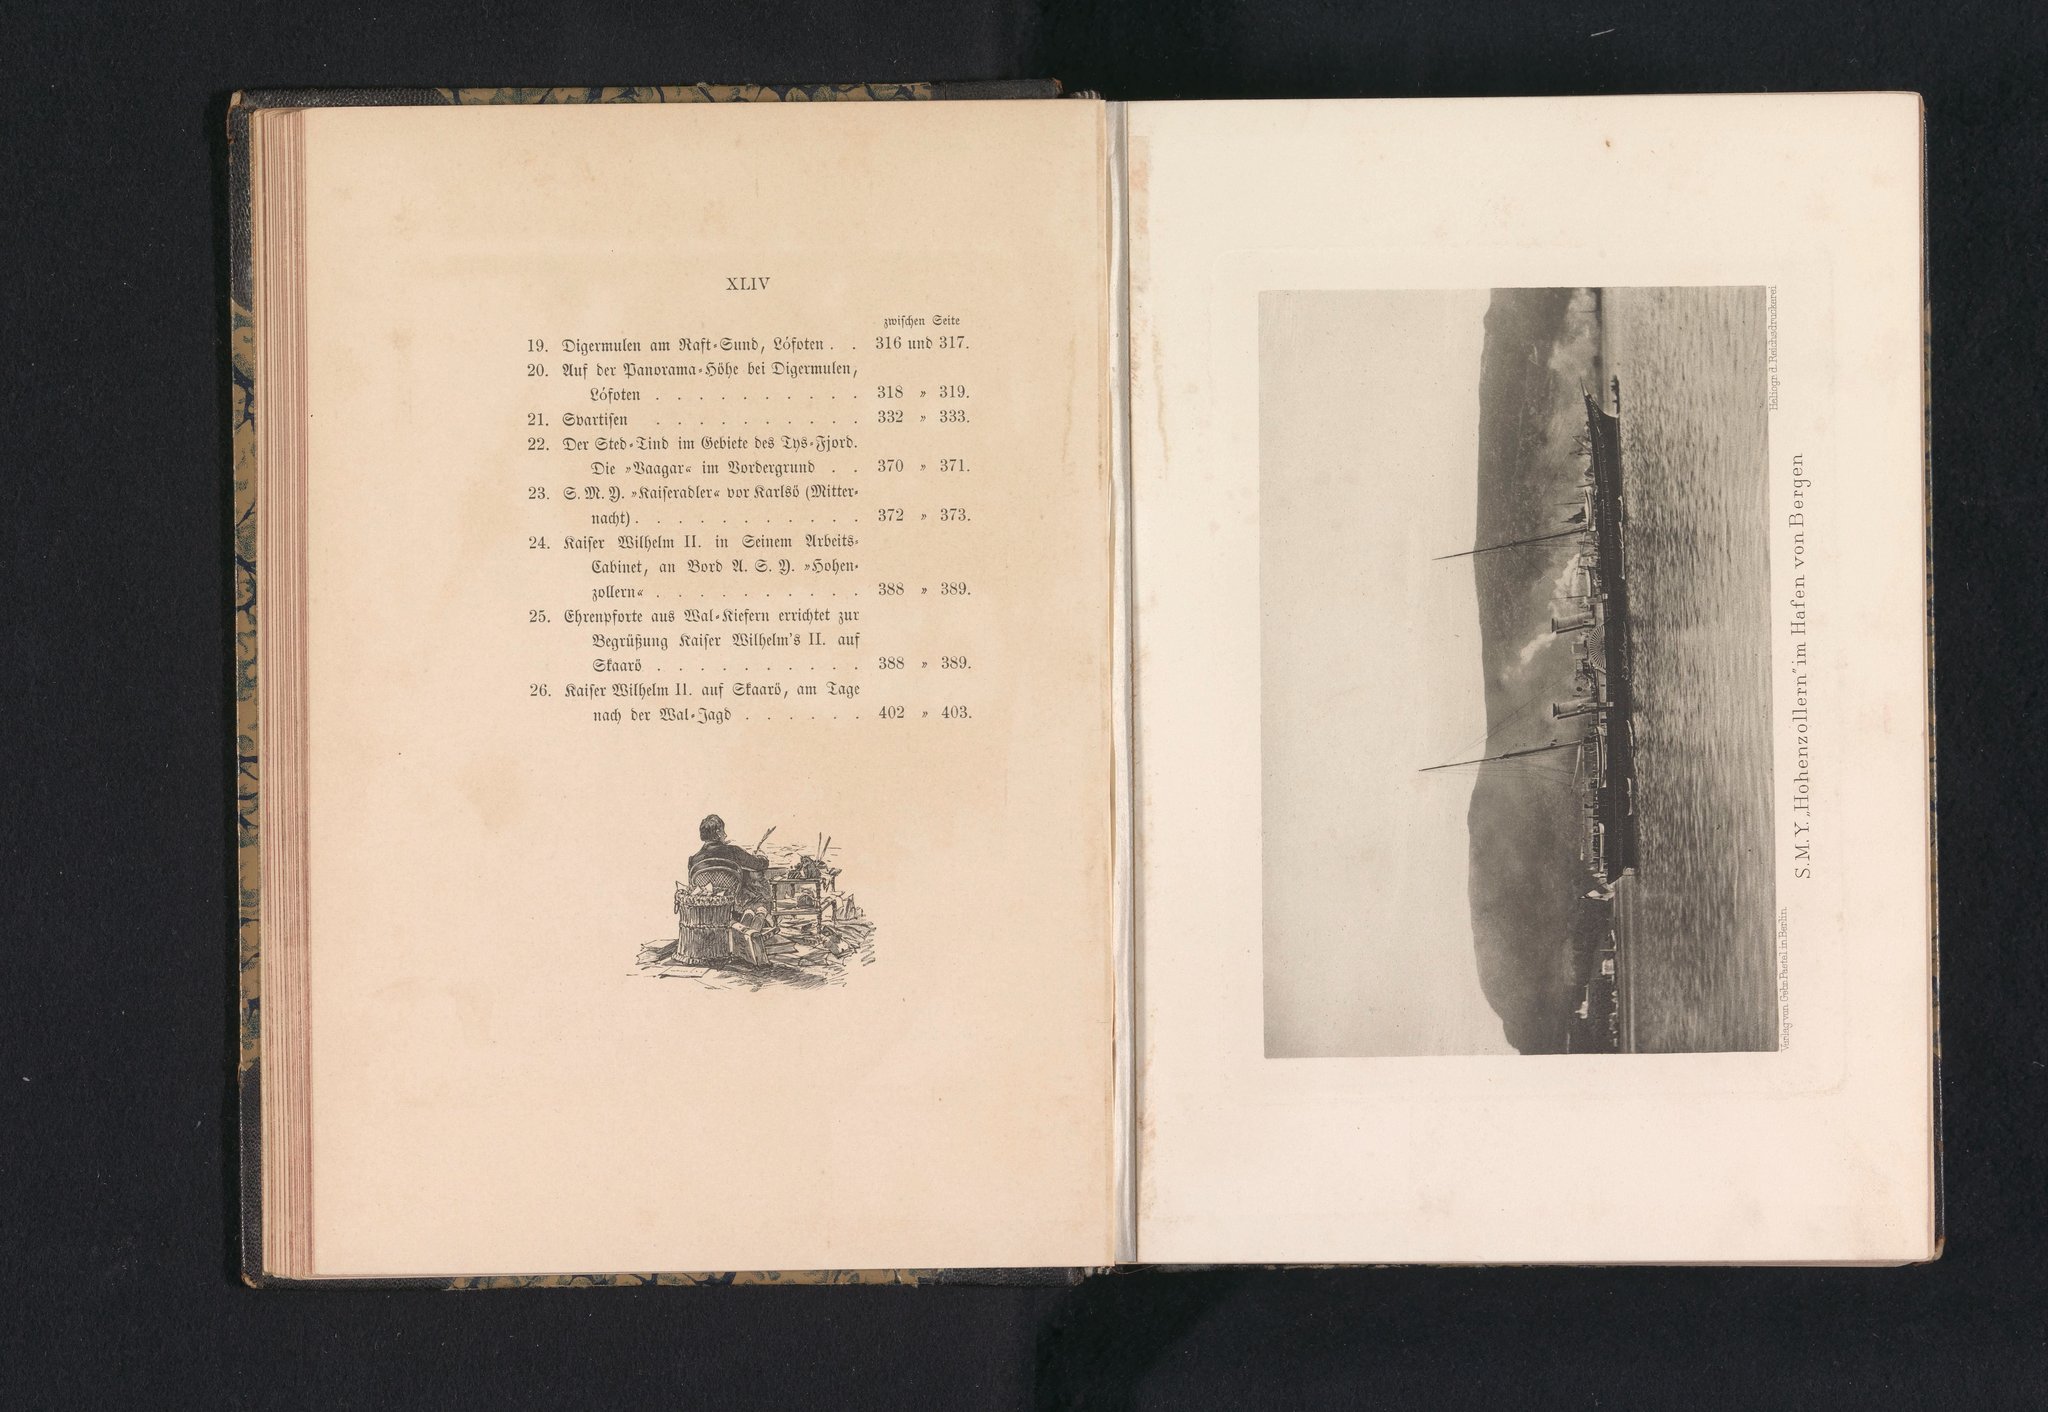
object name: page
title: Gezicht op het jacht Hohenzollern in de haven van Bergen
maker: Anonymous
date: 1889-1892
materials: paper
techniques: photoaquatint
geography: bergen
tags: harbour, ships (in general)